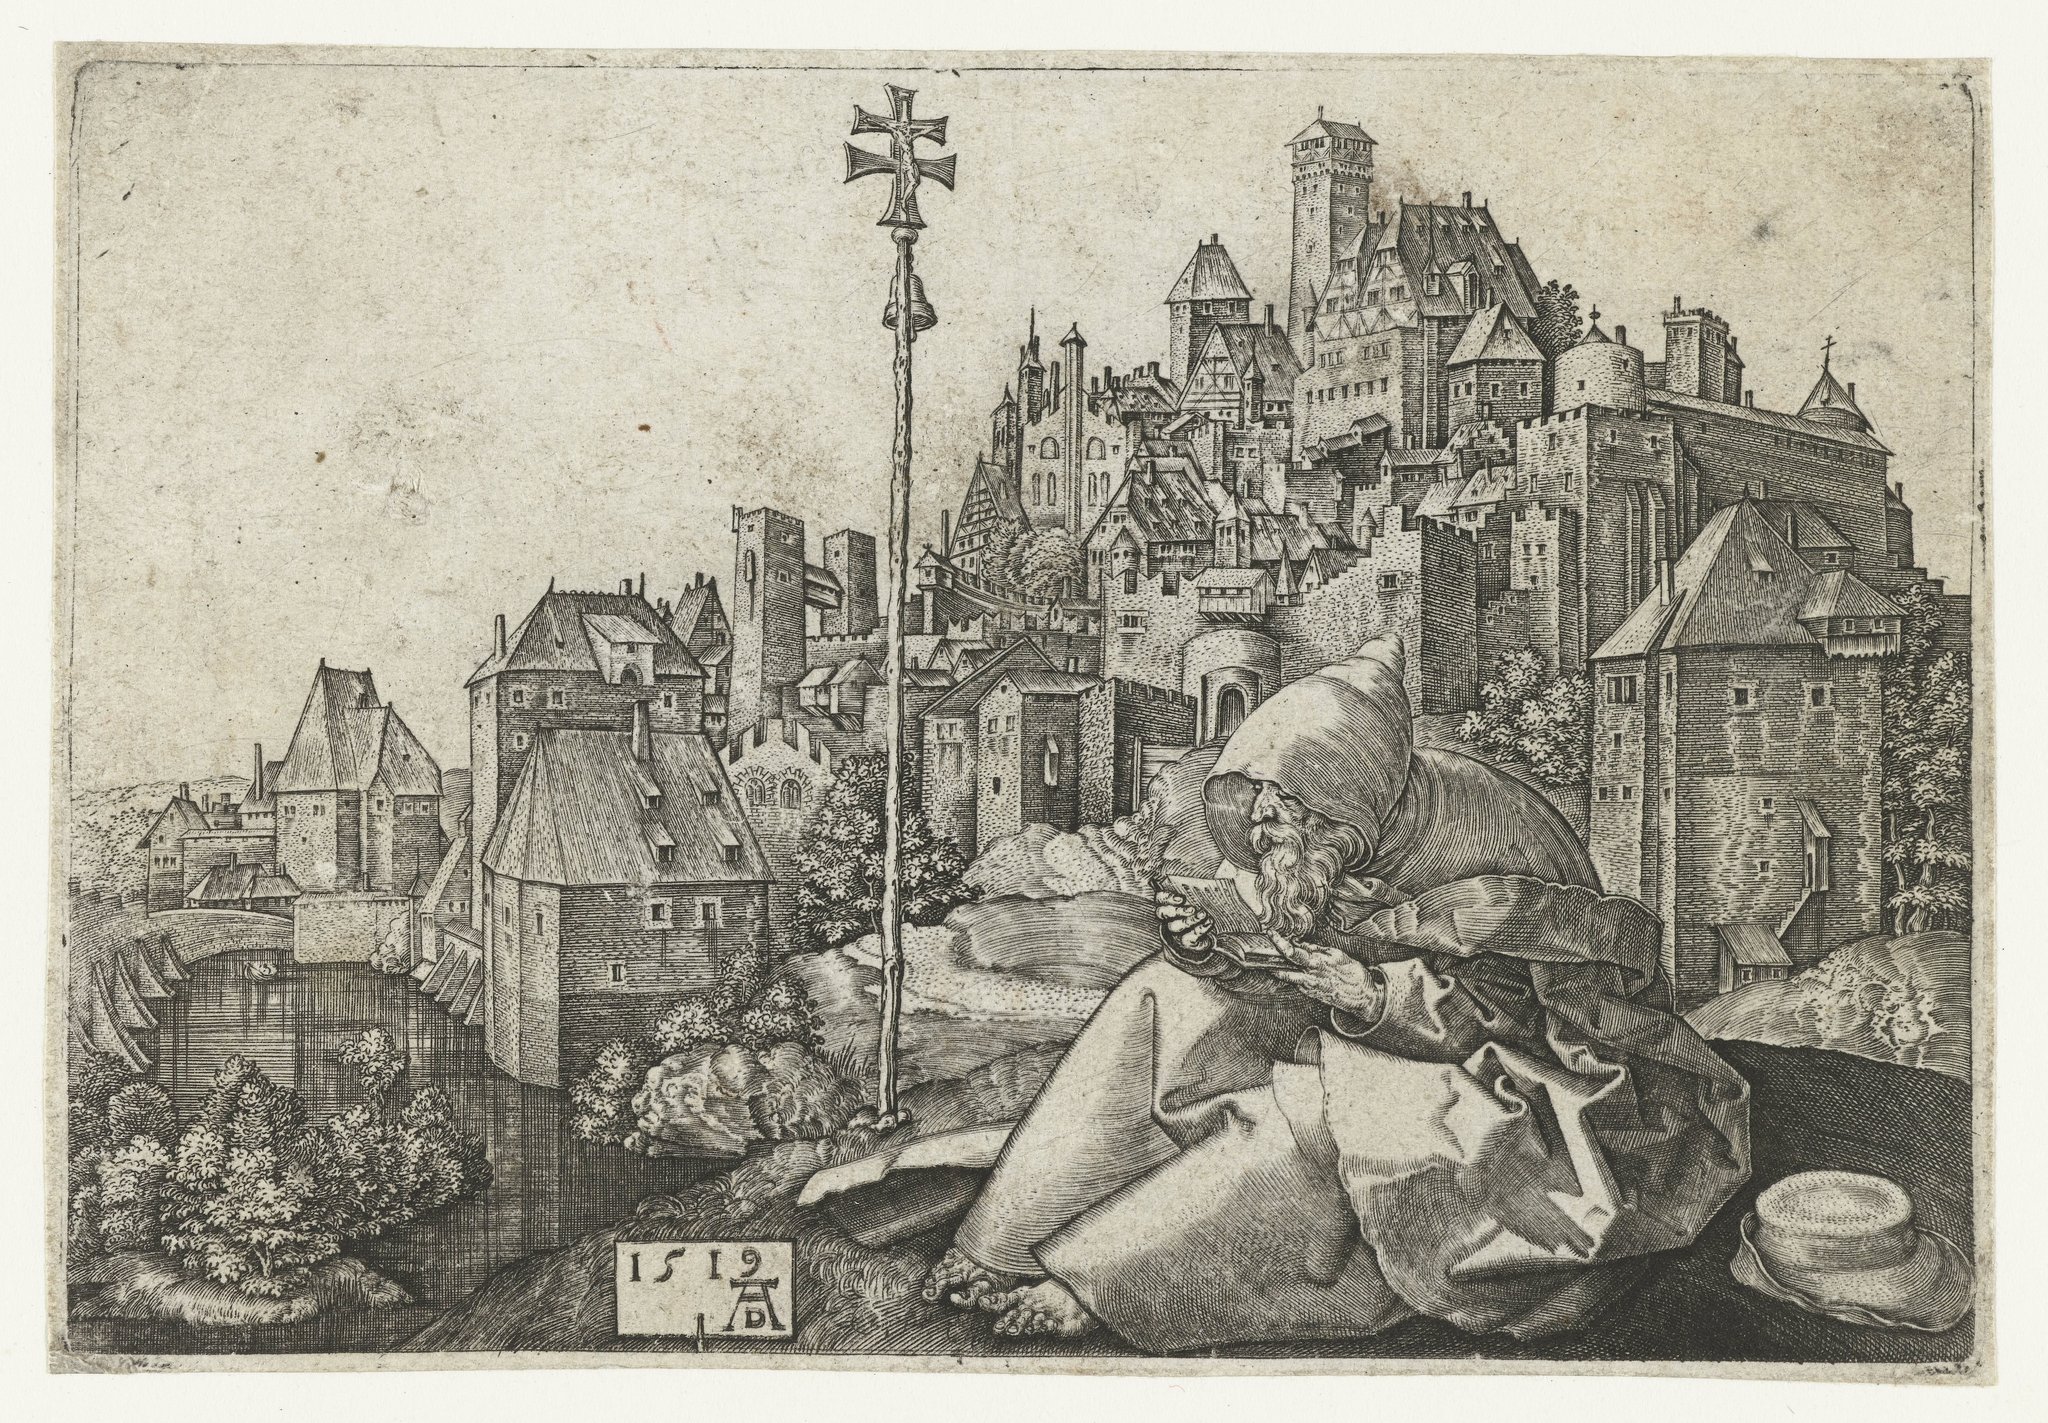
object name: print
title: De Heilige Antonius voor een stad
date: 1519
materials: paper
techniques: engraving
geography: germany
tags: the hermit antony abbot (antonius abbas) of egypt, also called the great; possible attributes: bell, book, t-shaped staff, flames, pig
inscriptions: collector's mark: Lugt 2228a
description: De Heilige Antonius zit op de grond te lezen, net buiten een stad. Naast hem staat een staf met een dubbelkruis en een klokje.